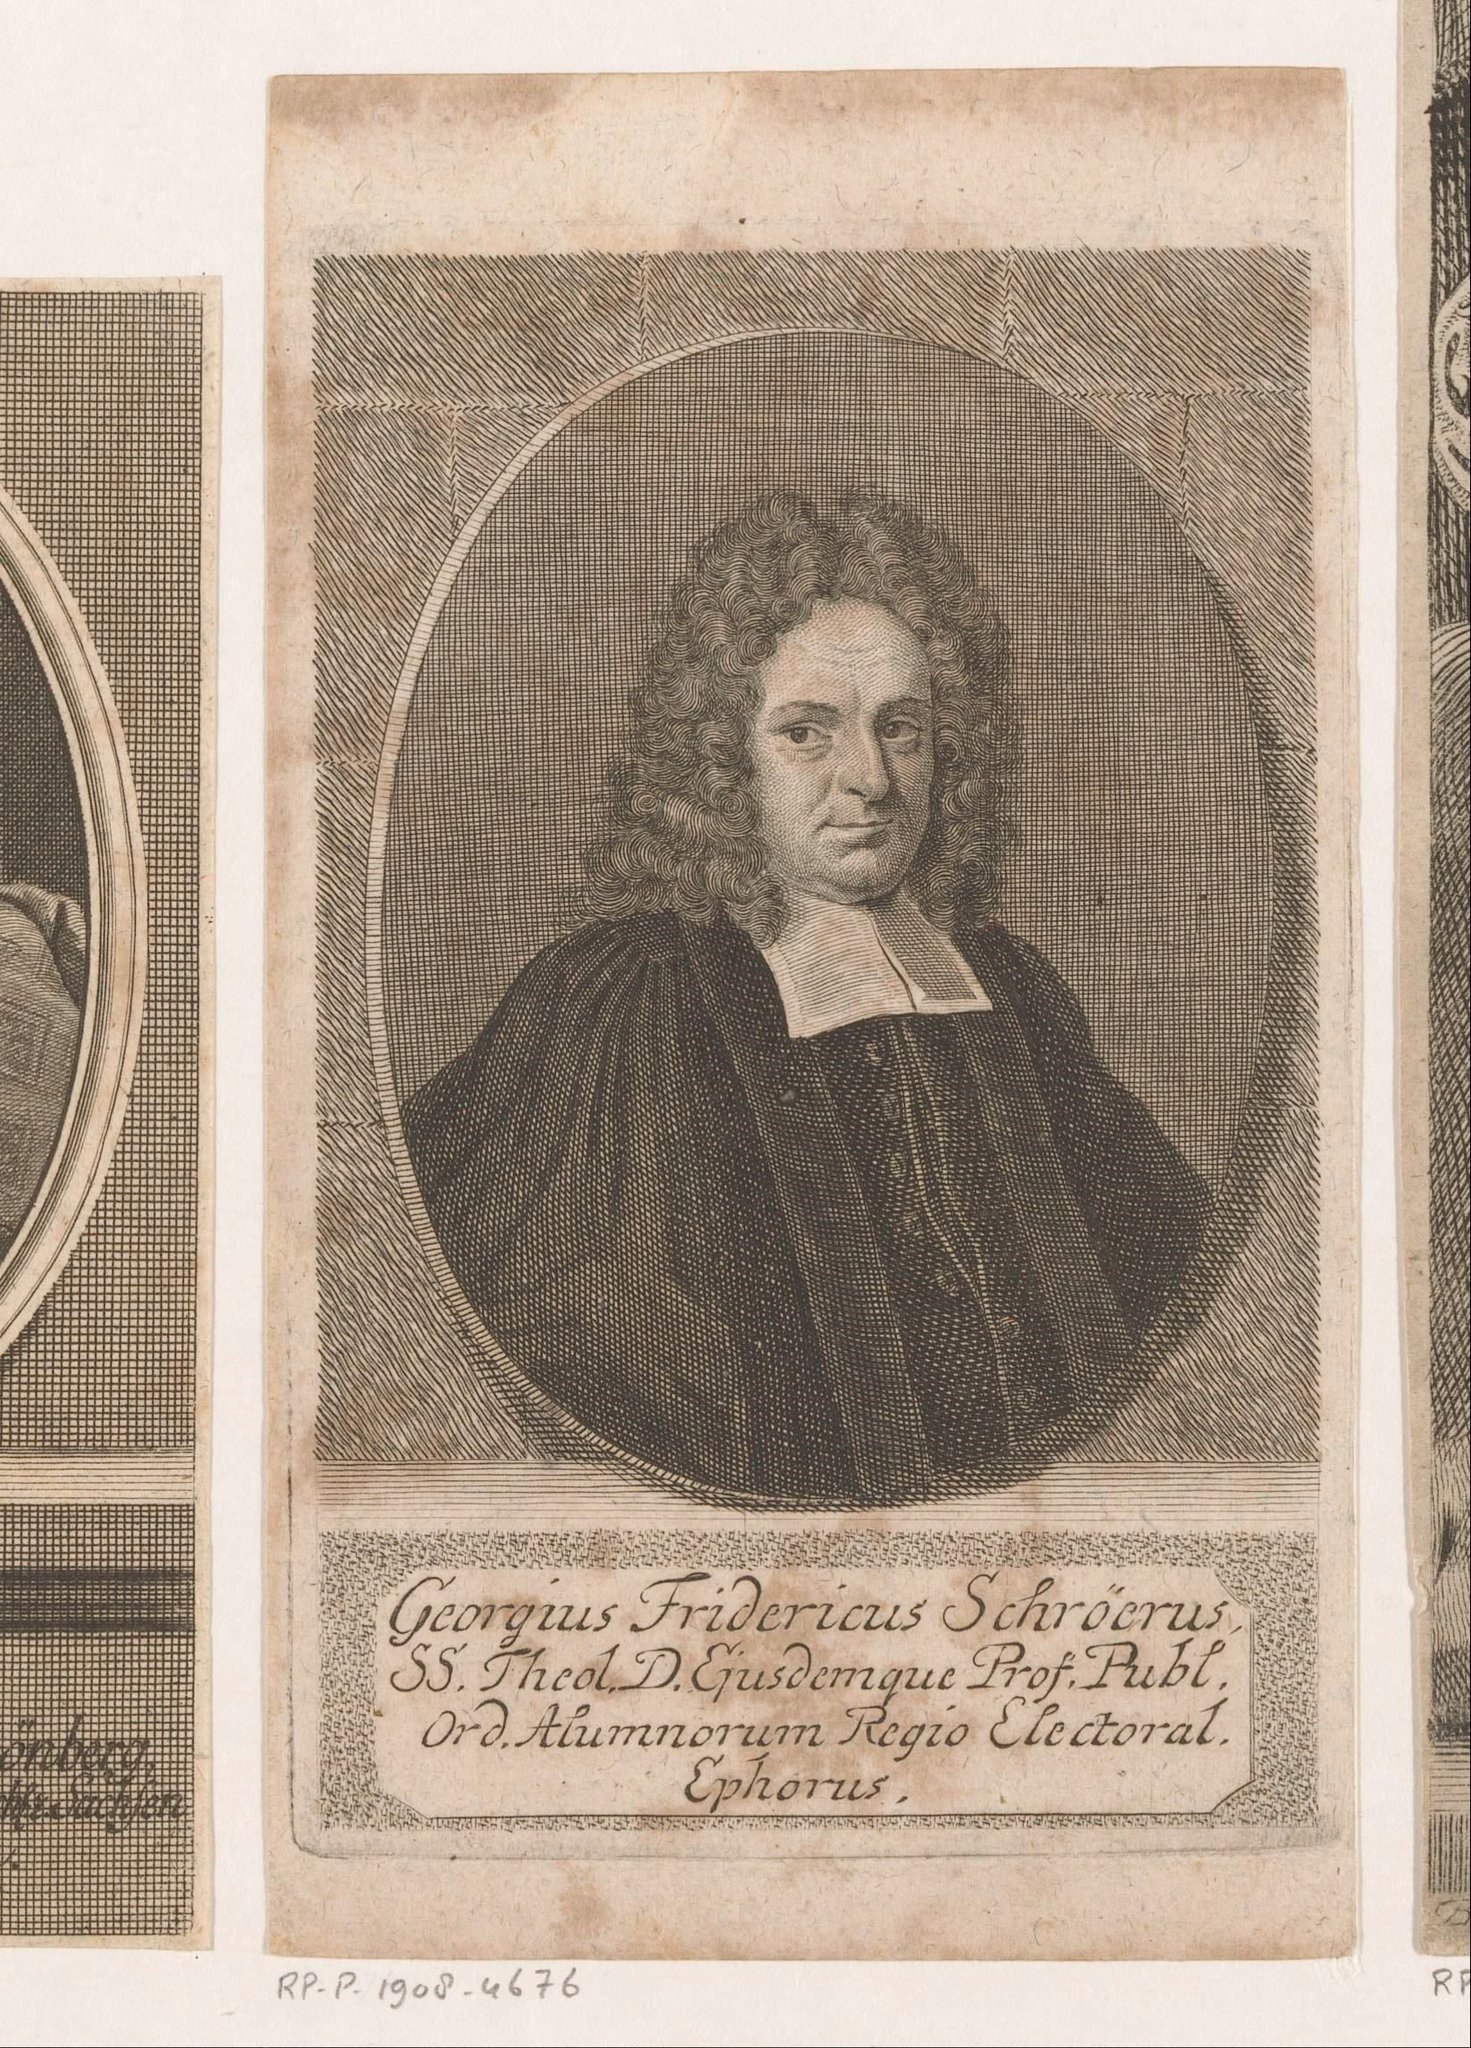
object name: print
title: Portret van Georg Friedrich Schröer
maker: martin bernigeroth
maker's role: print maker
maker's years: 1670-1733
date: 1712-1733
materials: paper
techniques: engraving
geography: leipzig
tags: historical persons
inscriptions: collector's mark: Lugt 2228